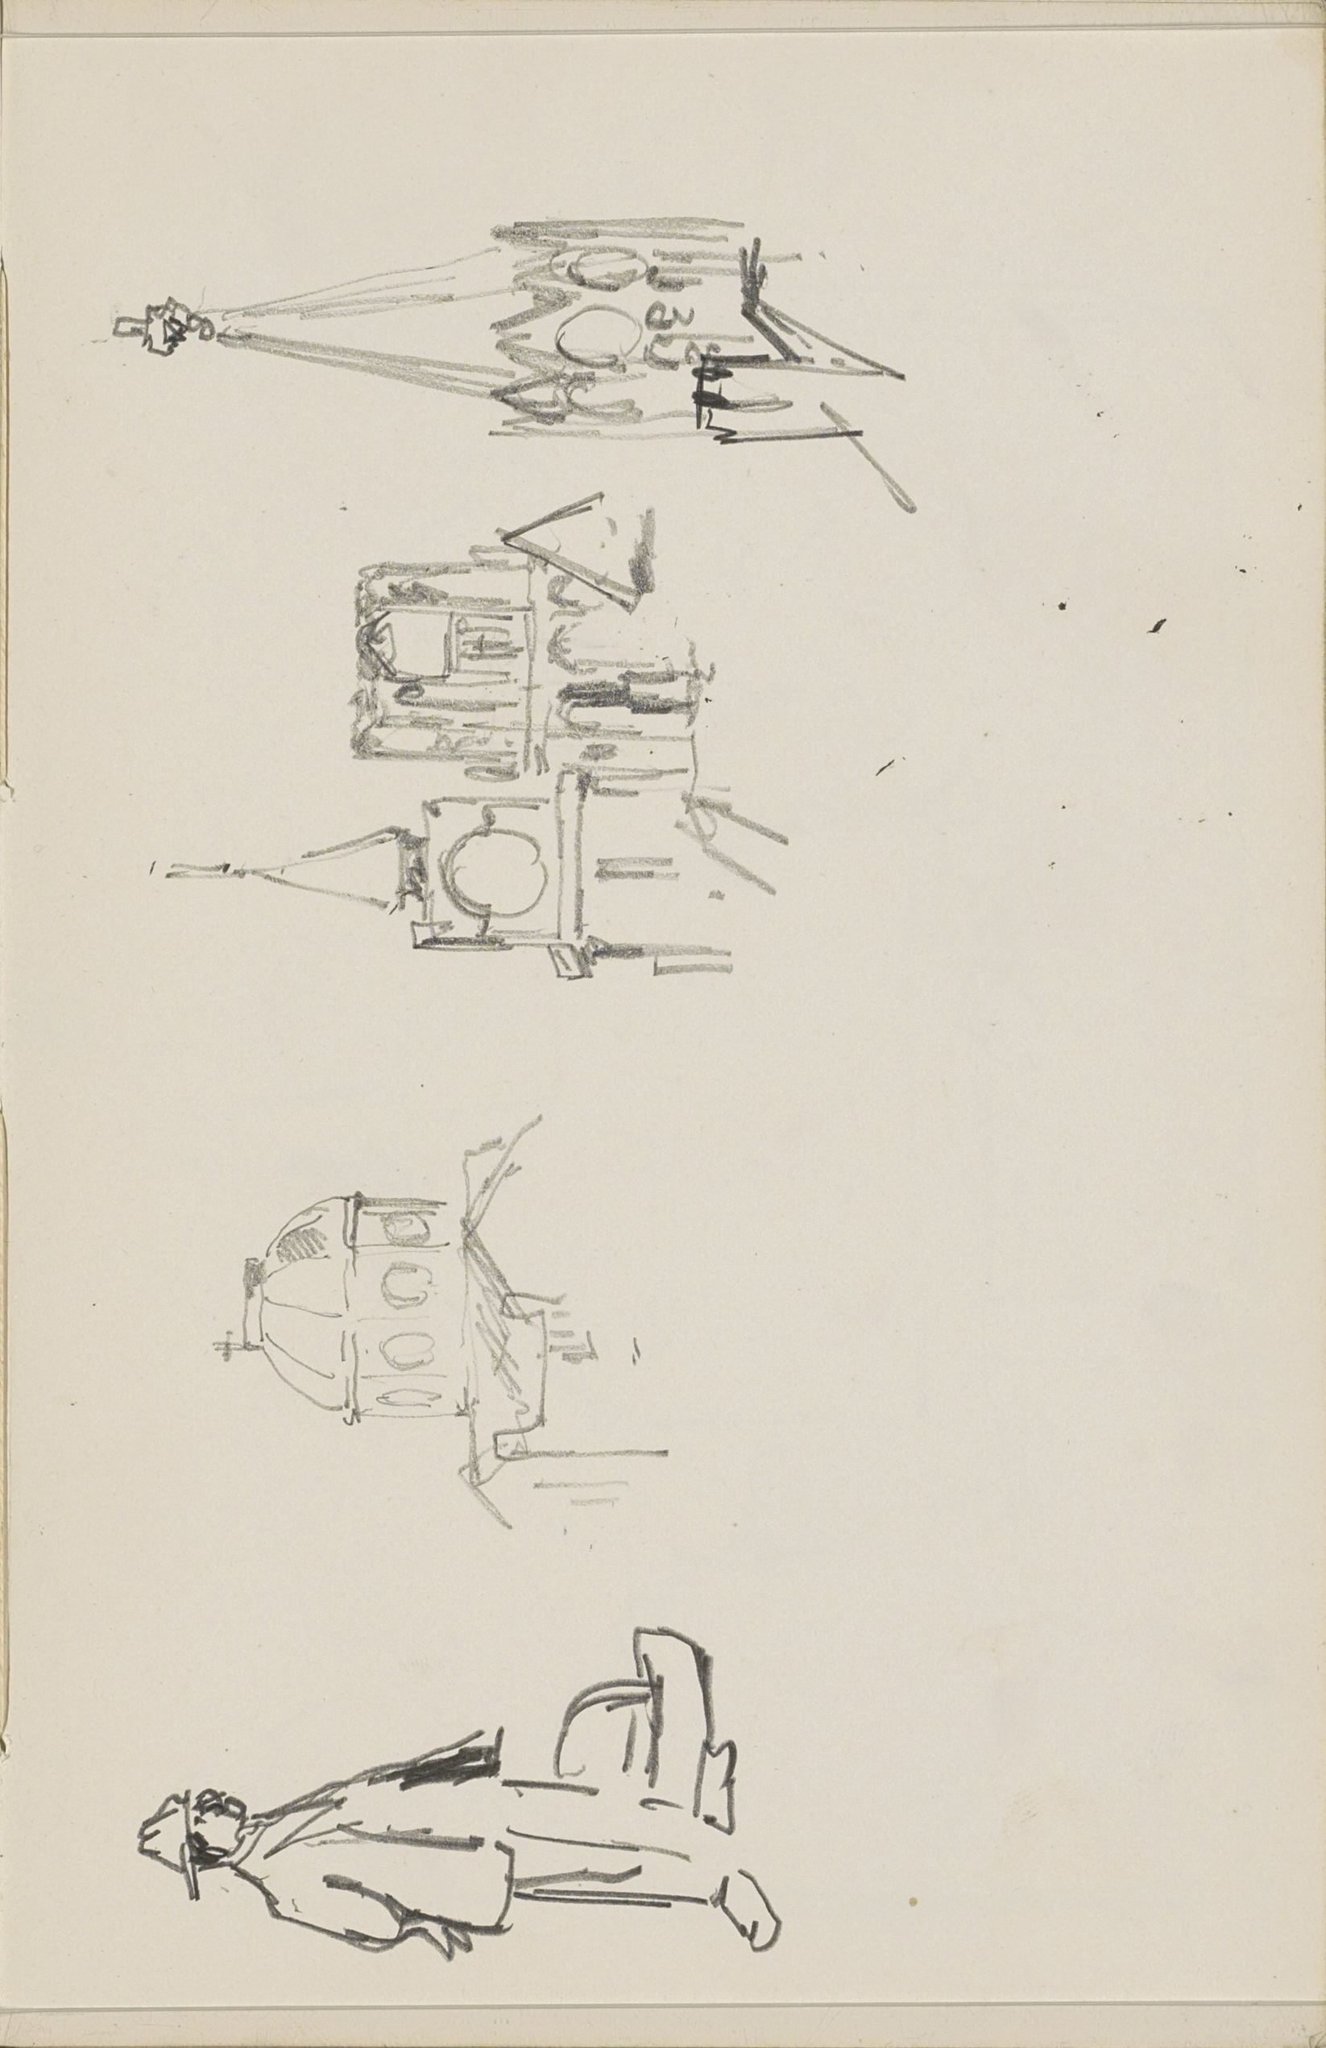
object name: sketchbook leaf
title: Torenspitsen, een koepeltoren en een staande man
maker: cornelis vreedenburgh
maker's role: draughtsman, print maker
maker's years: 1880-1946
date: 1890-1946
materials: paper, pencil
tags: standing figure, parts of church exterior and annexes: spire, parts of church exterior and annexes (with name)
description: Blad 17 recto uit een schetsboek met 41 bladen.